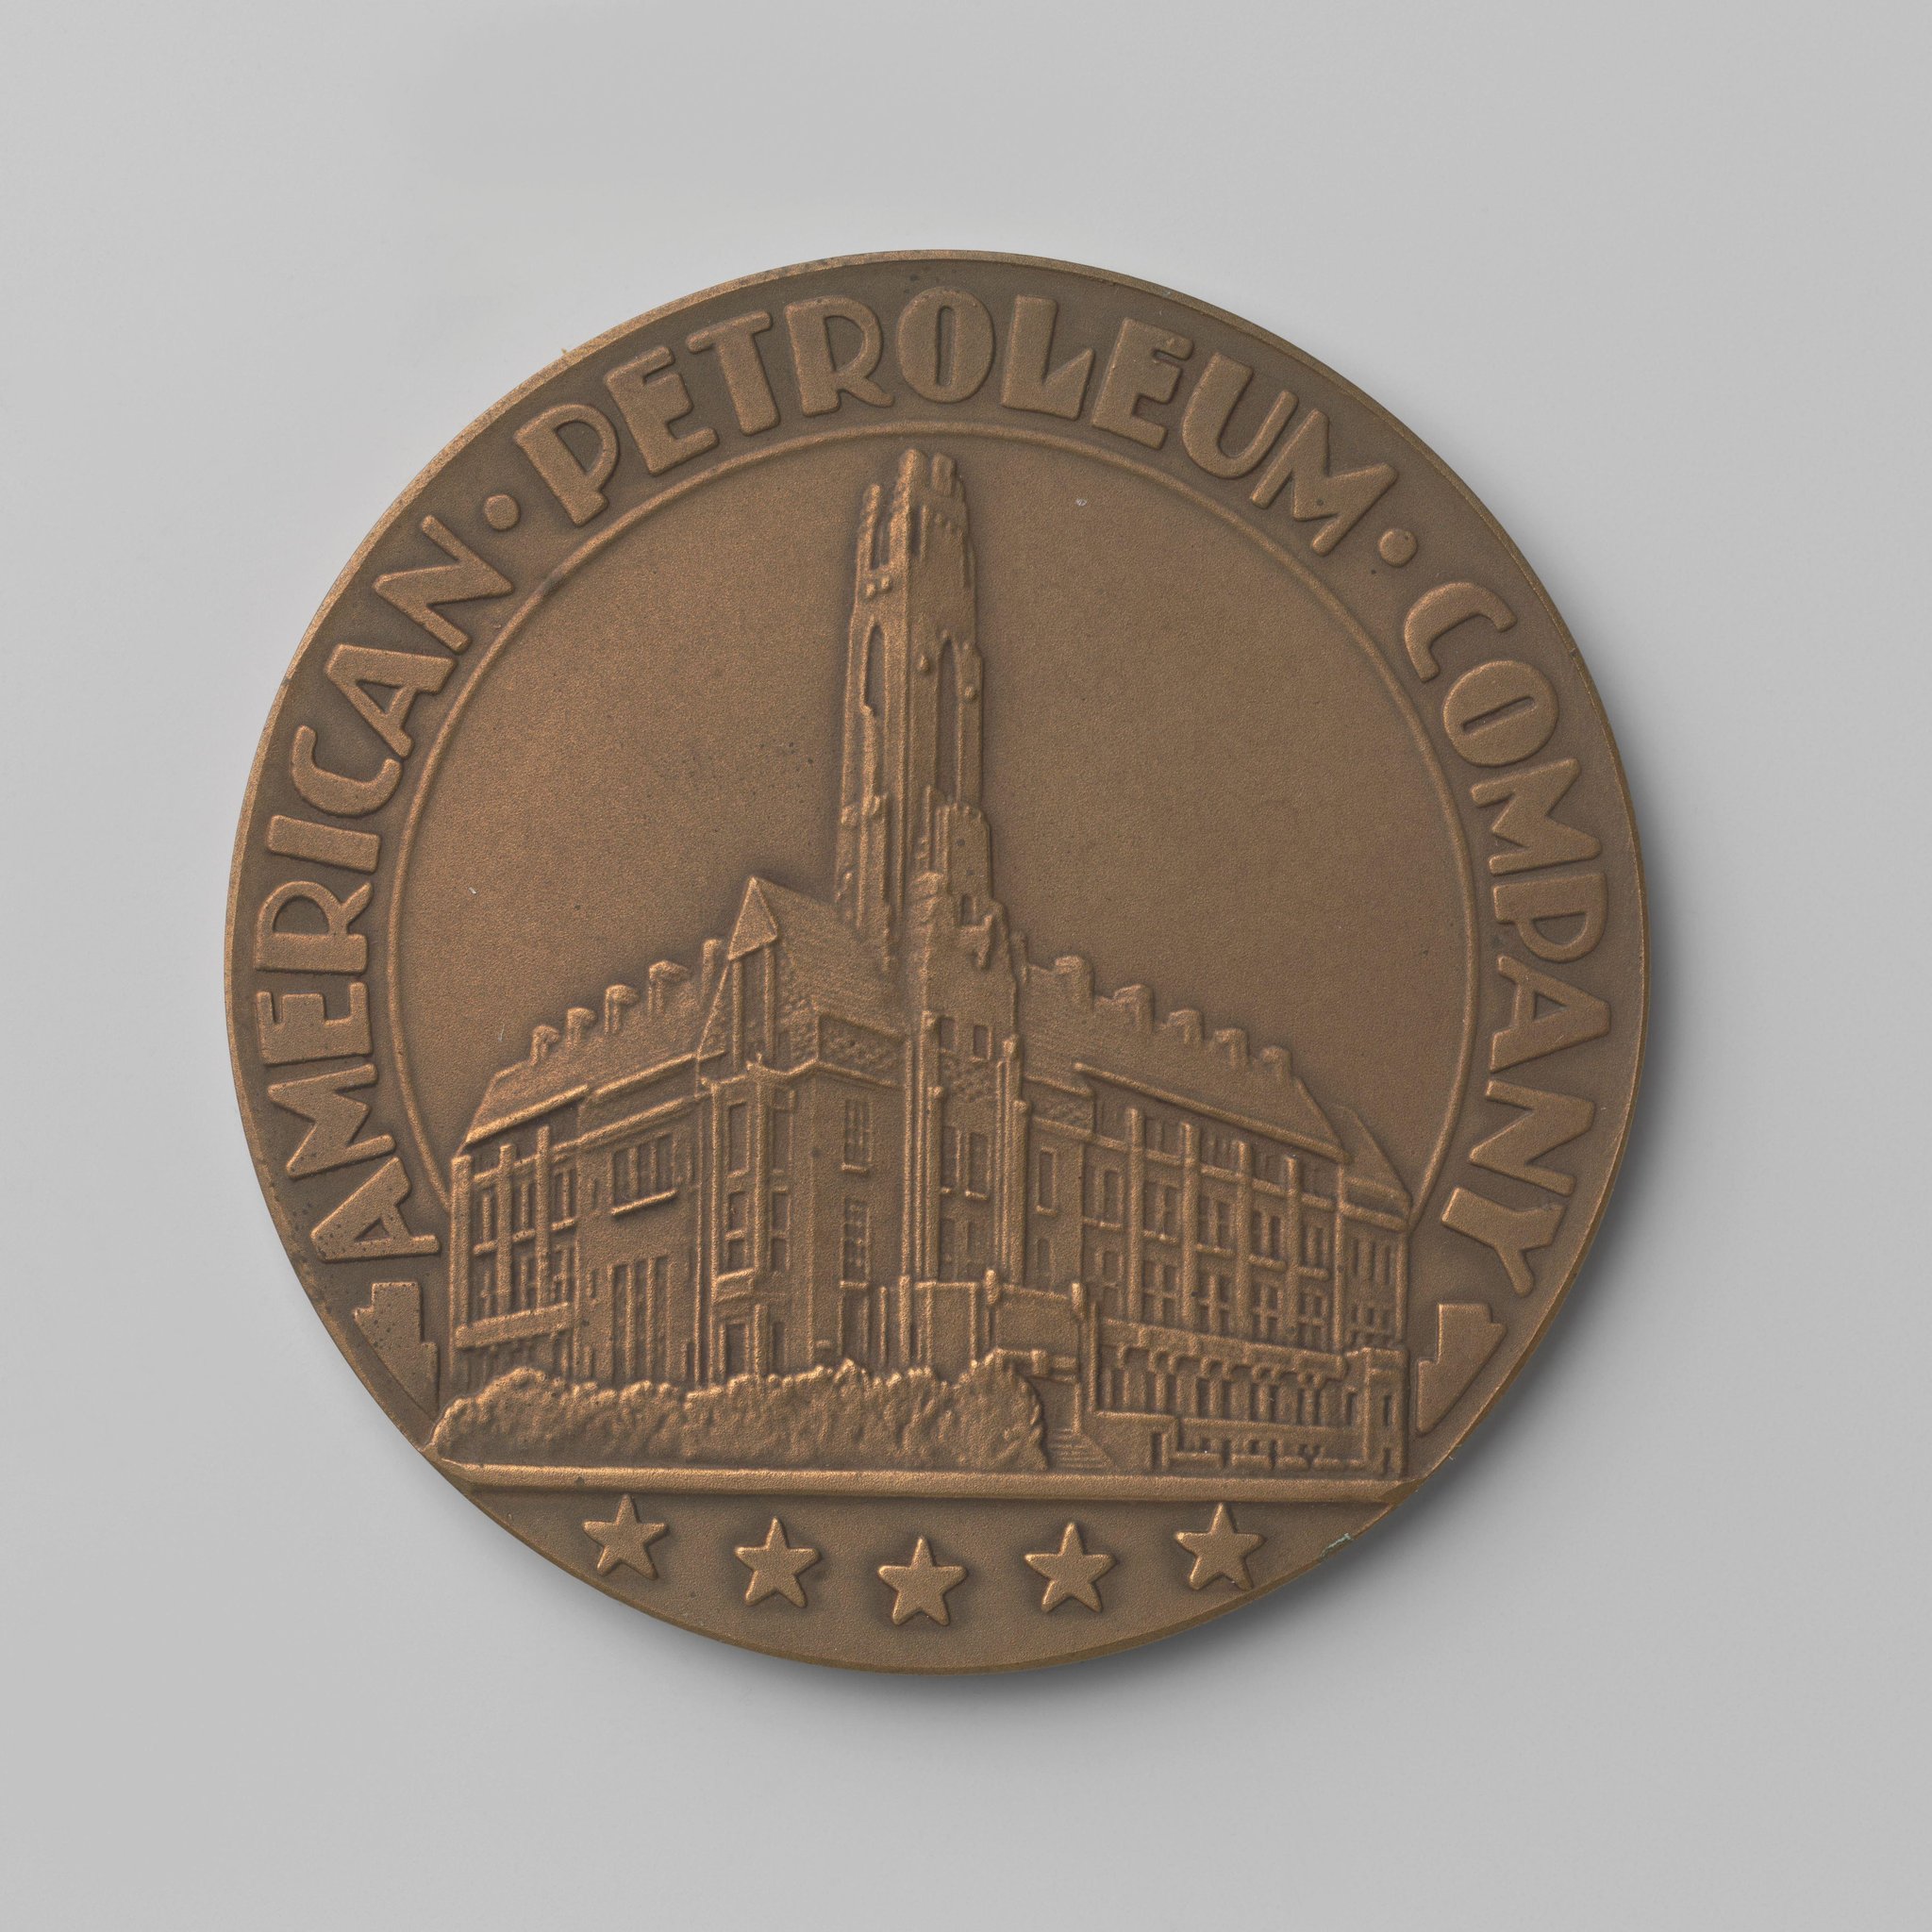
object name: medal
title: Prijspenning van de American Petroleum Company (1928)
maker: jacob jan van goor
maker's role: medailleur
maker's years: 1874-1956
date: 1928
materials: bronze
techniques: striking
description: Bronzen penning, op de voorzijde het gebouw Petrolea in Den Haag met omschrift, in afsnede vijf sterren, op de keerzijde een glad veld binnen een kring van vier series van vijf sterren en de letters APC, met verklaring.